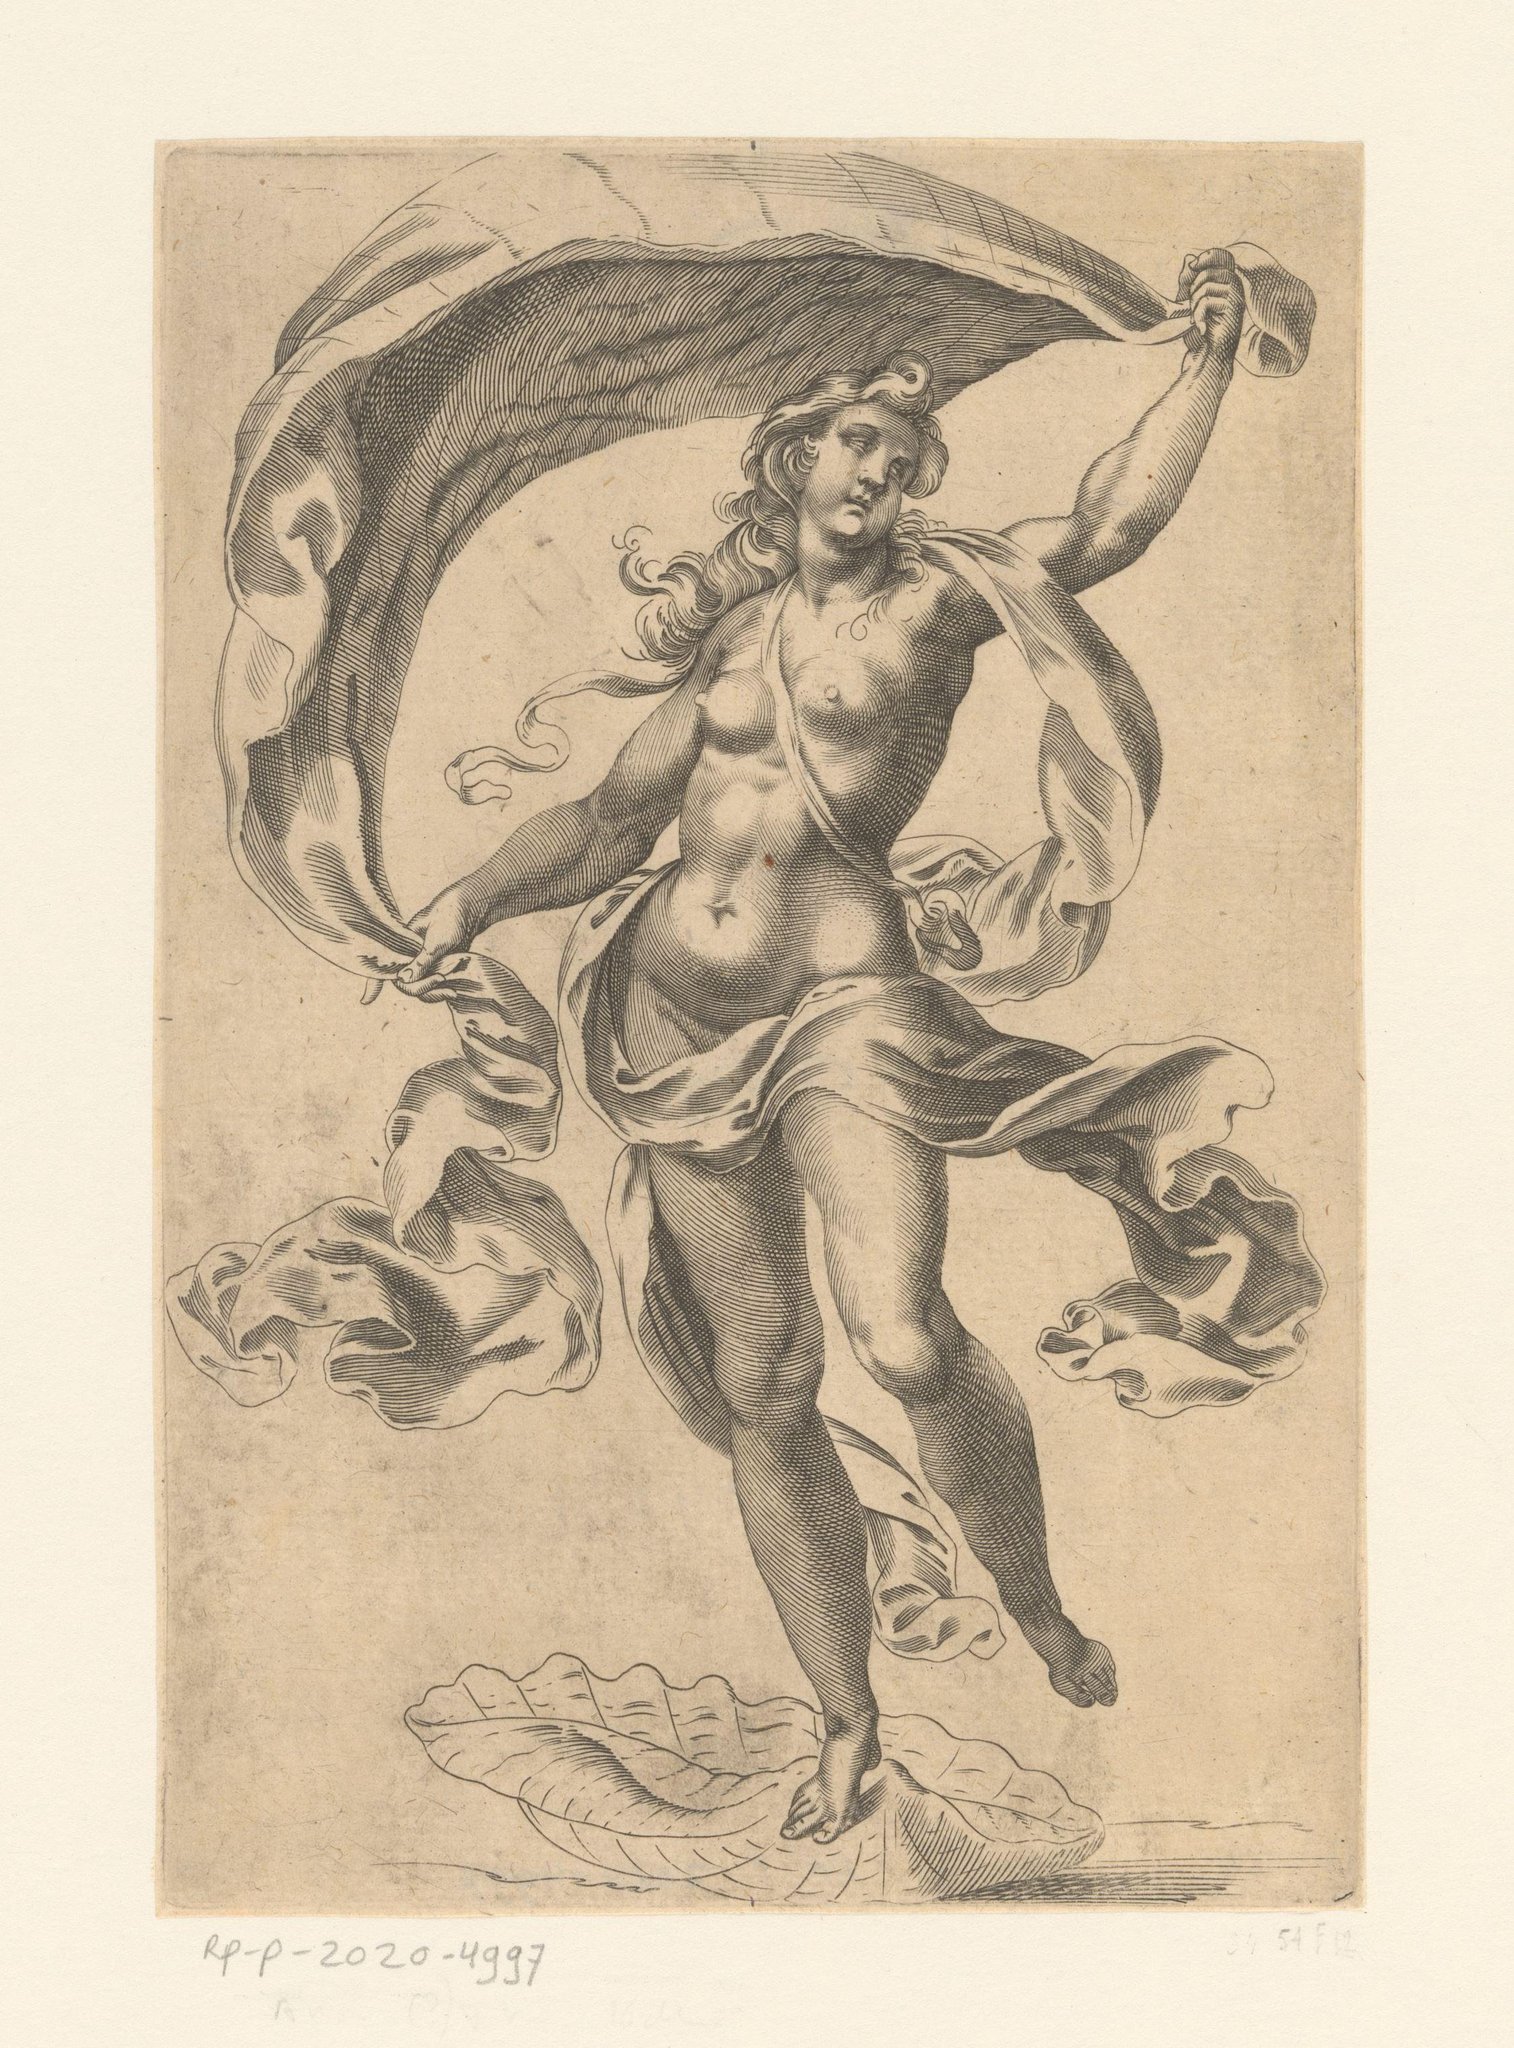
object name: print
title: Venus Marina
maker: Anonymous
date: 1570-1620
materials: paper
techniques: engraving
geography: italy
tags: venus, standing on a shell, sails with her veil over the water (alternatively she is riding on a dolphin): venus marina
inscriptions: collector's mark: Lugt 2228